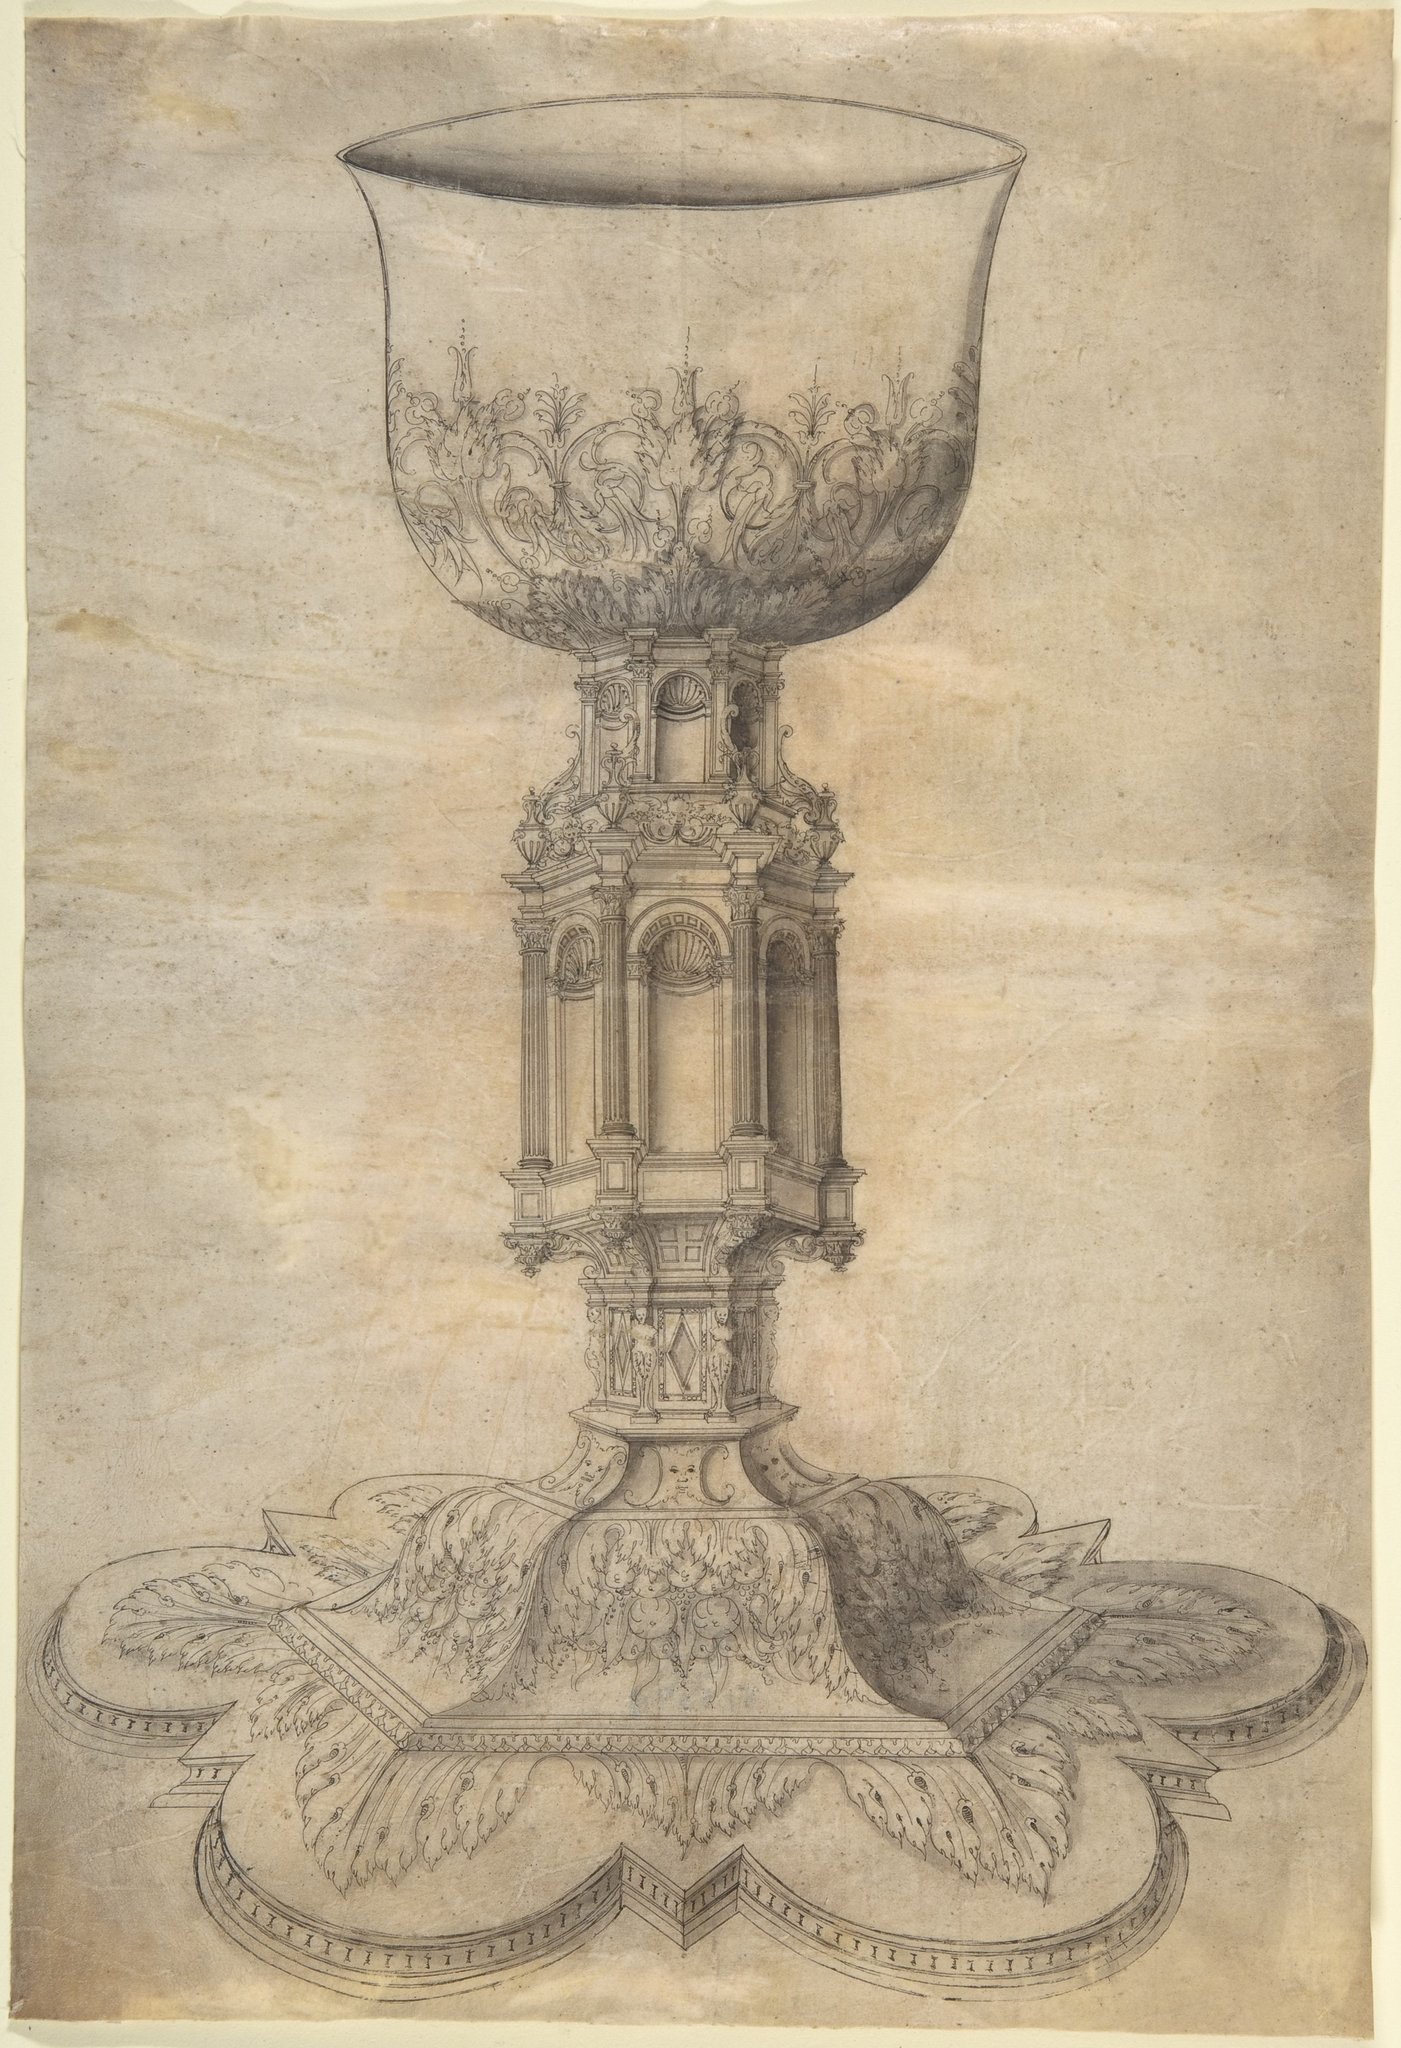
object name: drawing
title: Design for a Chalice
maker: anonymous, netherlandish, late 16th century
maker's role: artist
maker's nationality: netherlandish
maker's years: 1550-1600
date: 1501-1600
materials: ink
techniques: brush, pen, wash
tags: chalices